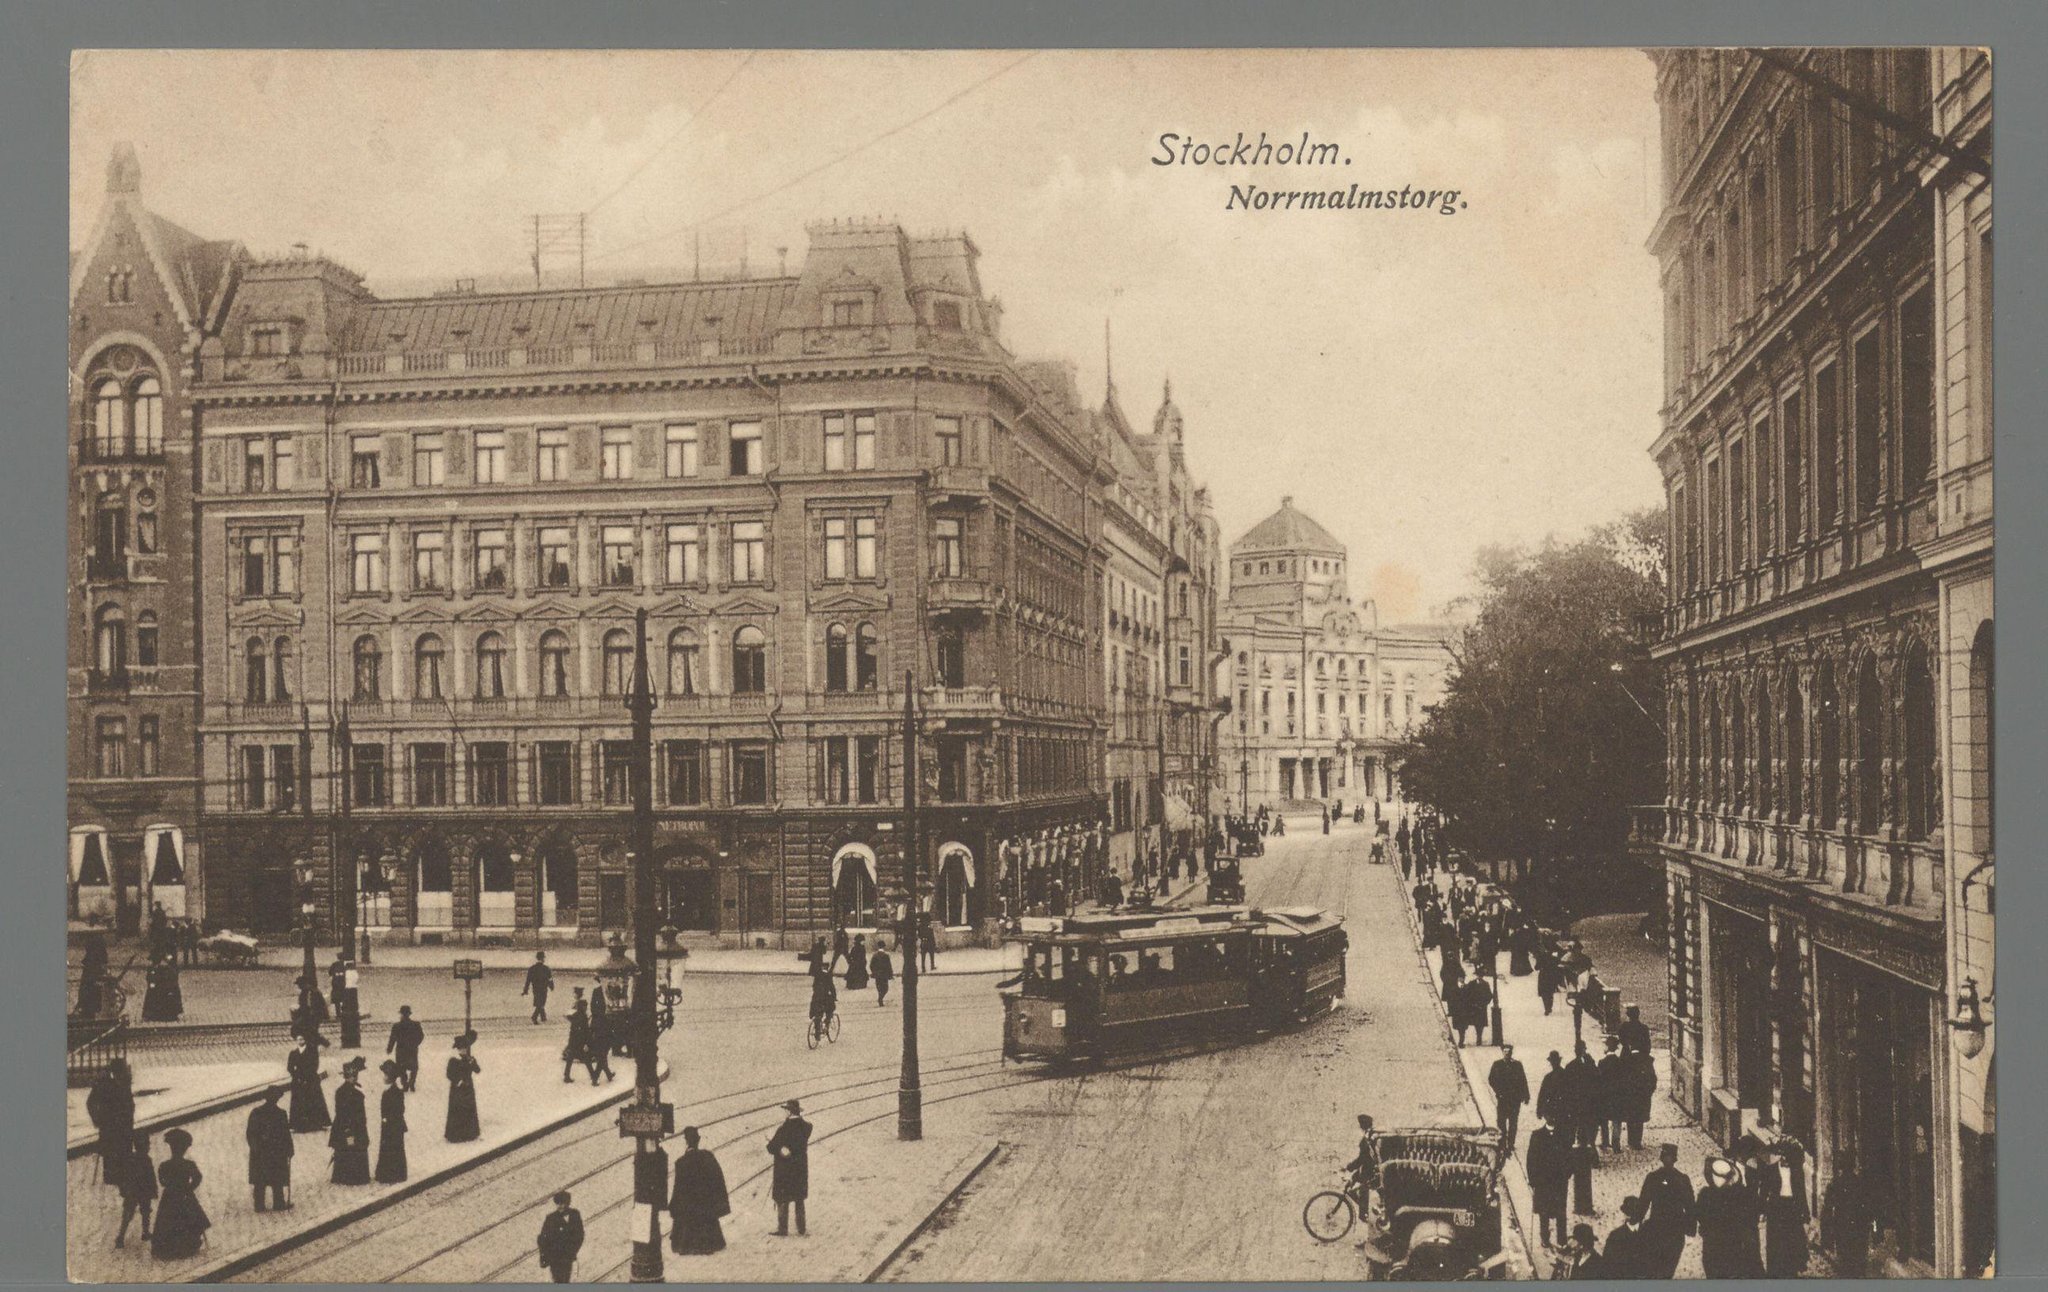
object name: ansichtkaart, prentbriefkaart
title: Stockholm. Norrmalmstorg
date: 1912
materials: cardboard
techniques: photograph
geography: stockholm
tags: square, place, circus, etc., tram, street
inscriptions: date